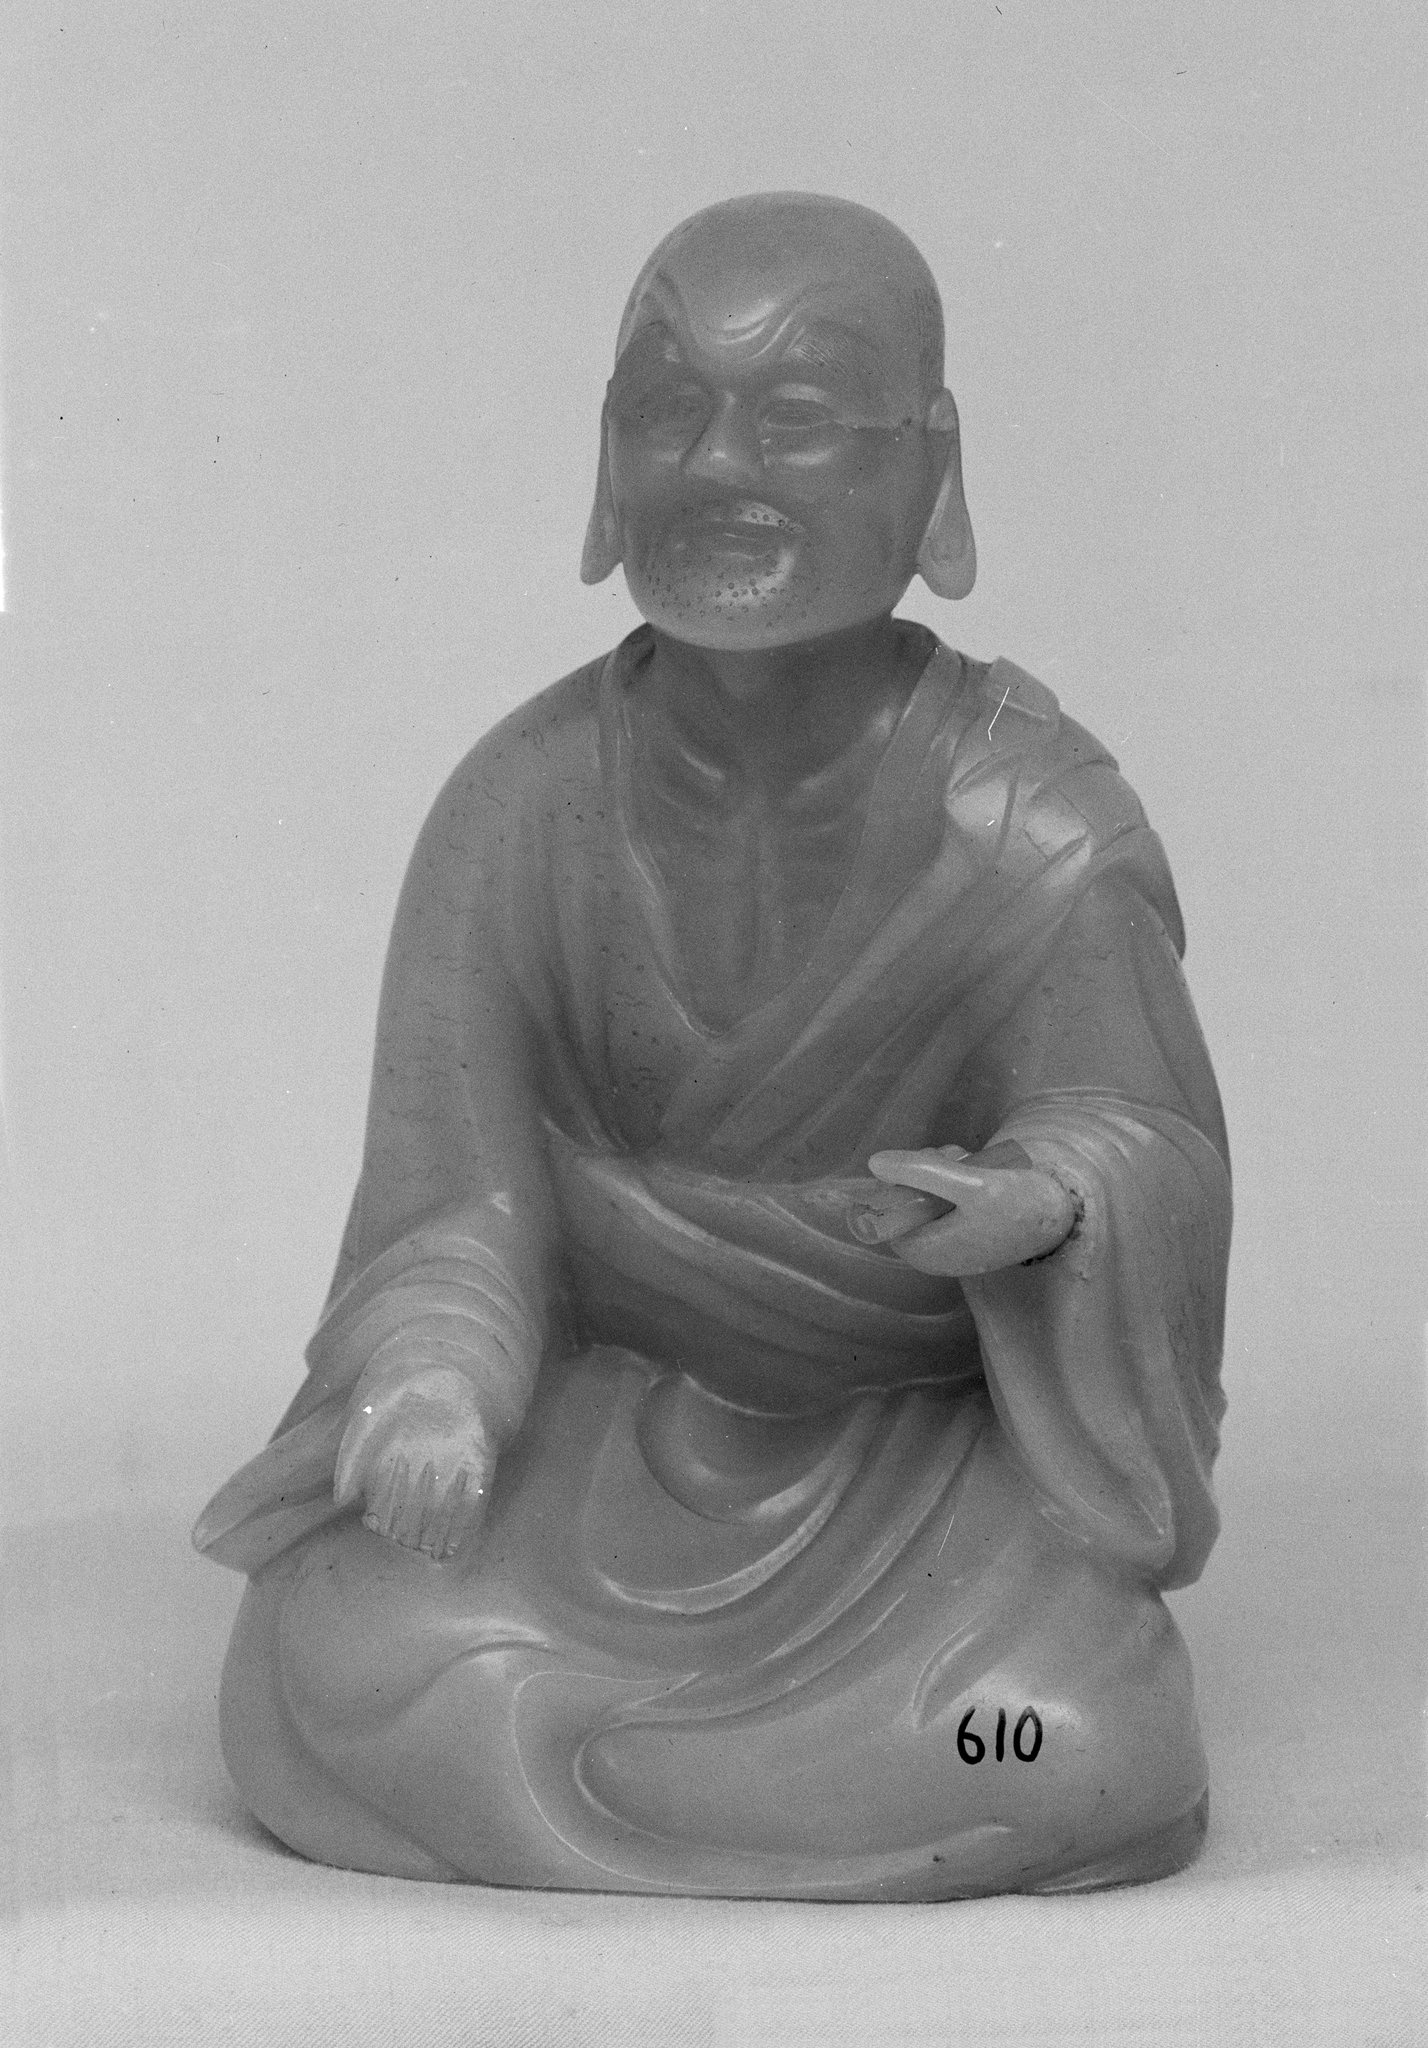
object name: figure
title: Luohan (Arhat)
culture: chinese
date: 1701-1800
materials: jade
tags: men,buddhism